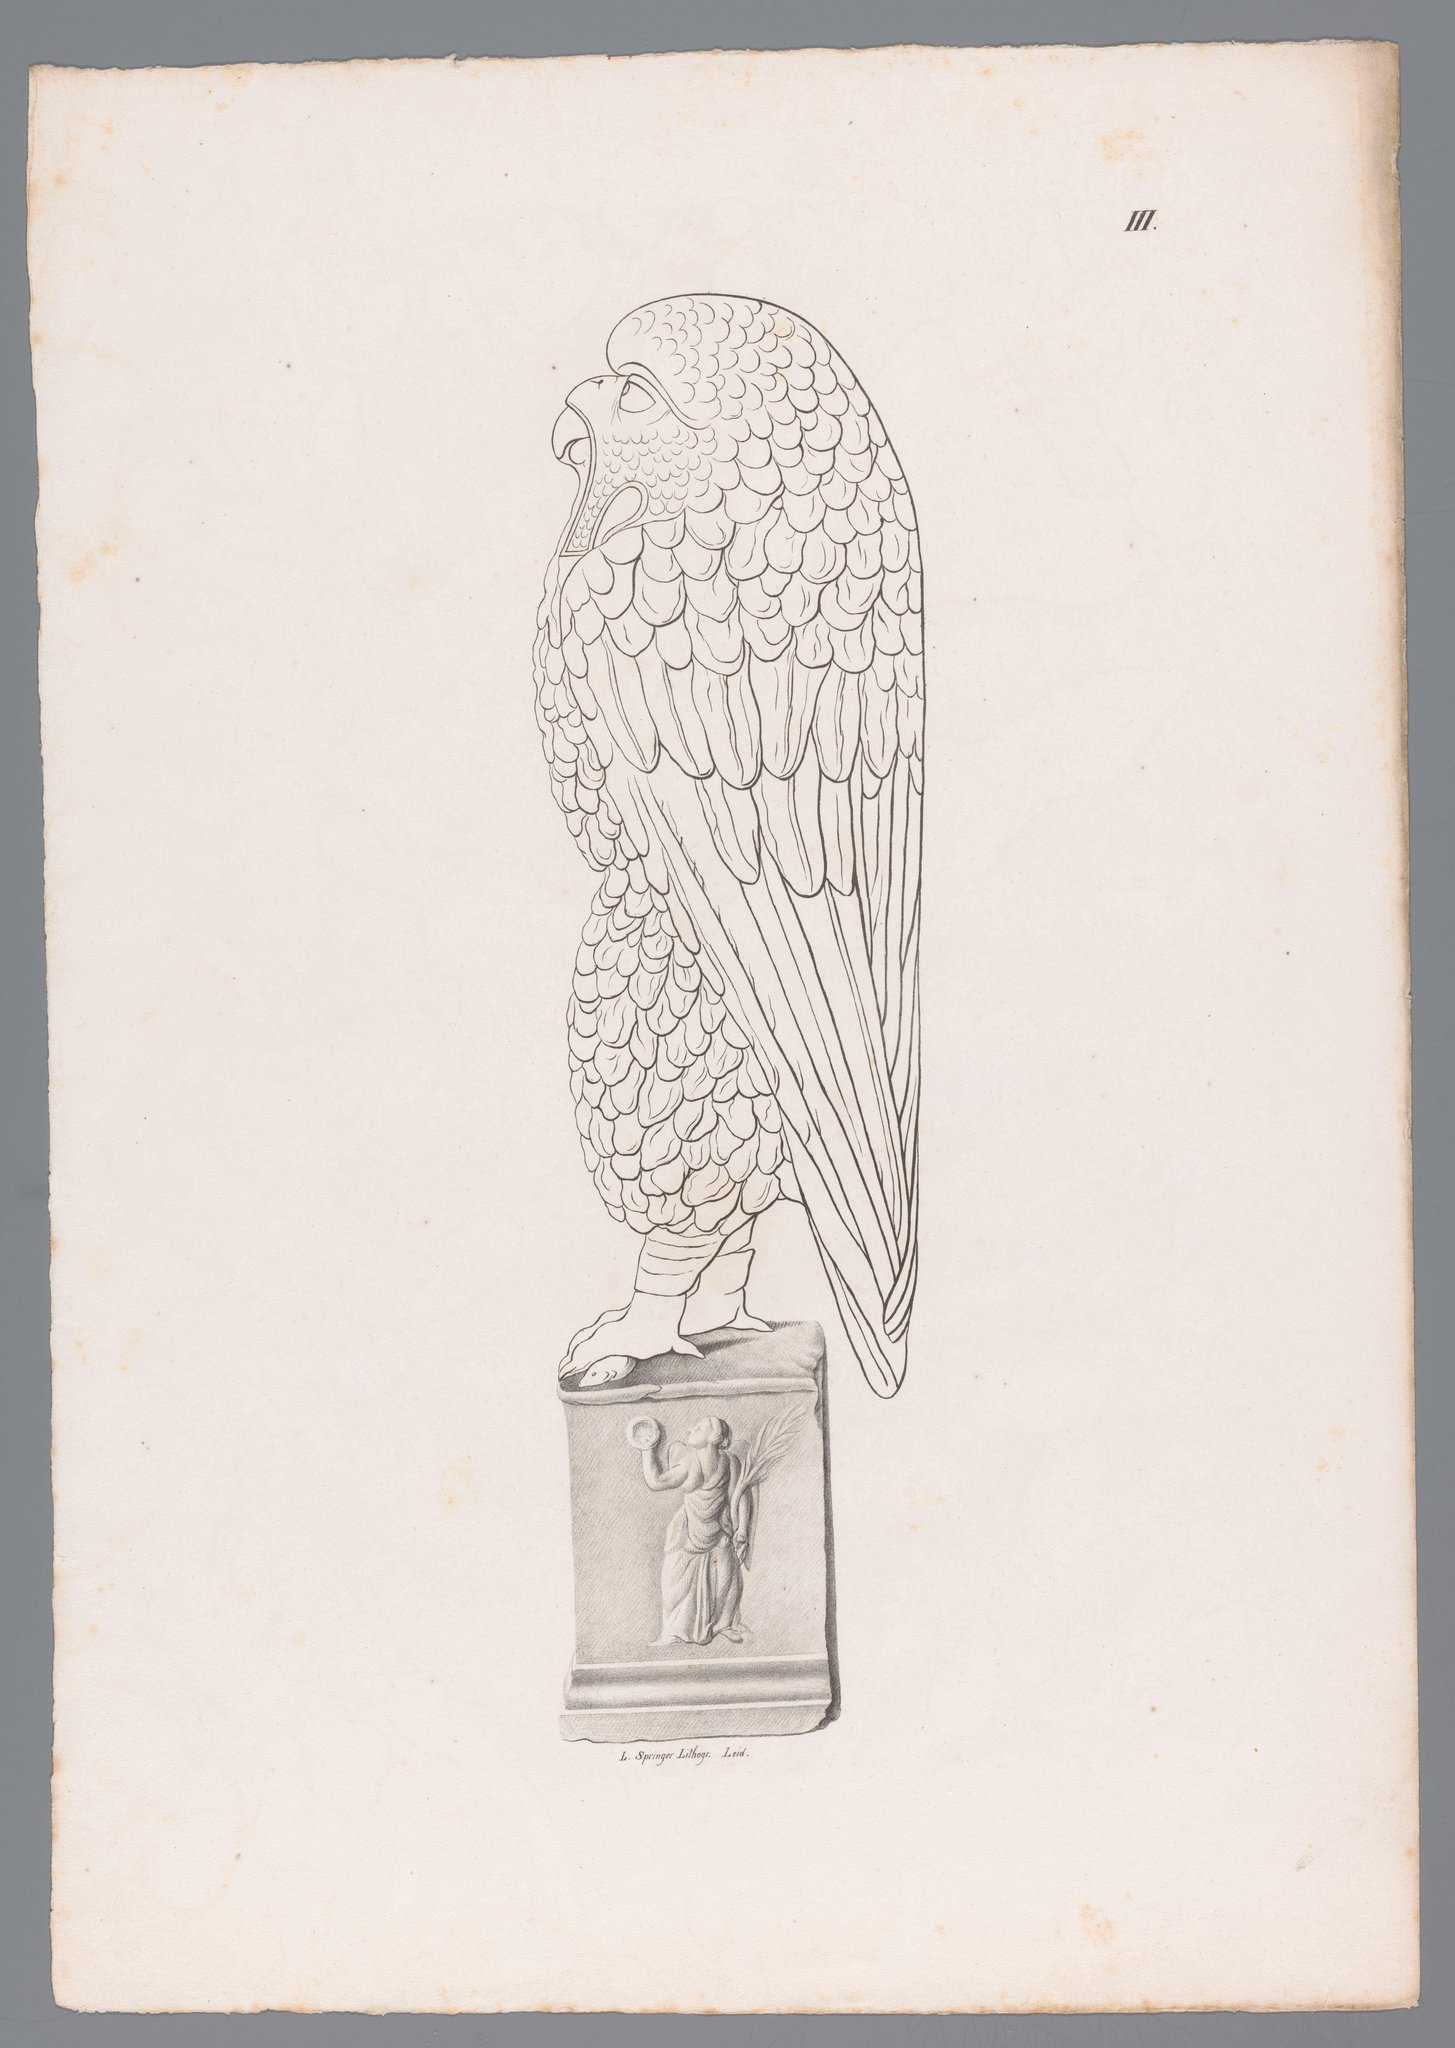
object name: print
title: Beeld van een uil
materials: paper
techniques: lithograph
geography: leiden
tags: owls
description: Prent uit: Reuvens, Caspar Jacob Christian. Lettres à M. Letronne (...) sur les papyrus bilingues et Grecs (...) Atlas, 1830. Naar de Uil van Thoms in de collectie van het Rijksmuseum van Oudheden te Leiden (Inventarisnr. ZM-7).